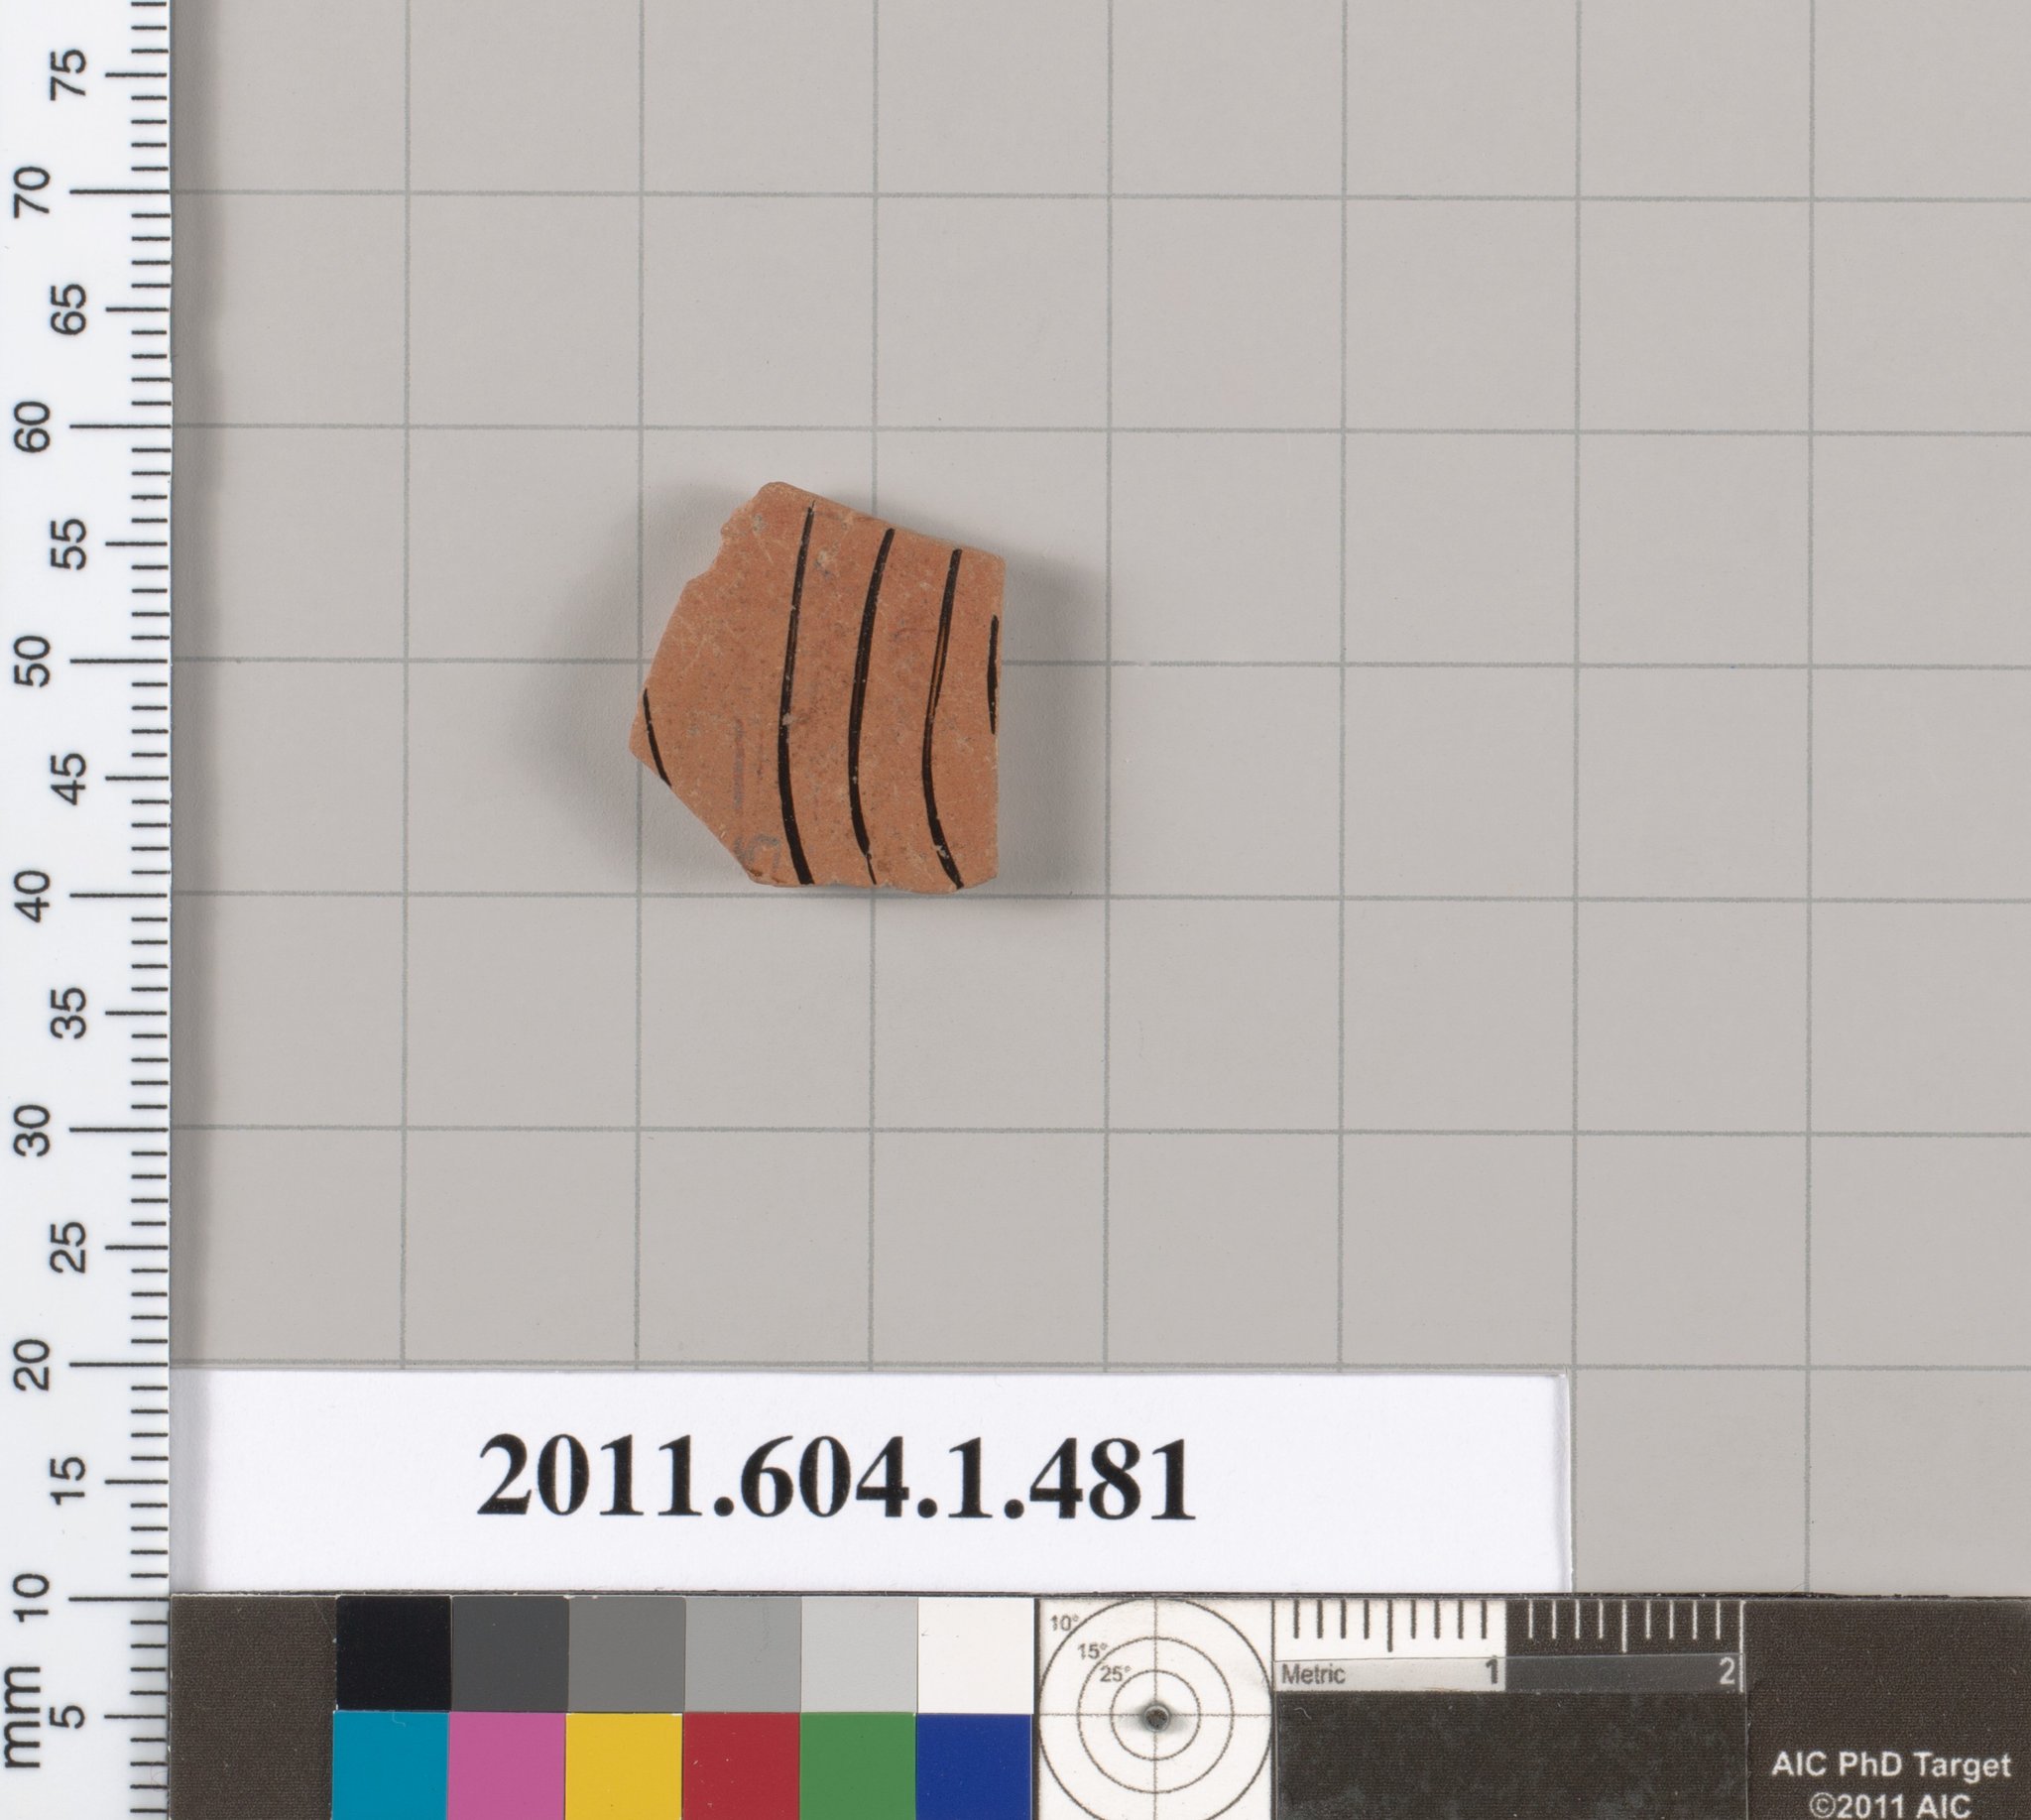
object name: kylix fragment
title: Terracotta fragment of a kylix (drinking cup)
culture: greek, attic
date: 490-480 BCE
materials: terracotta